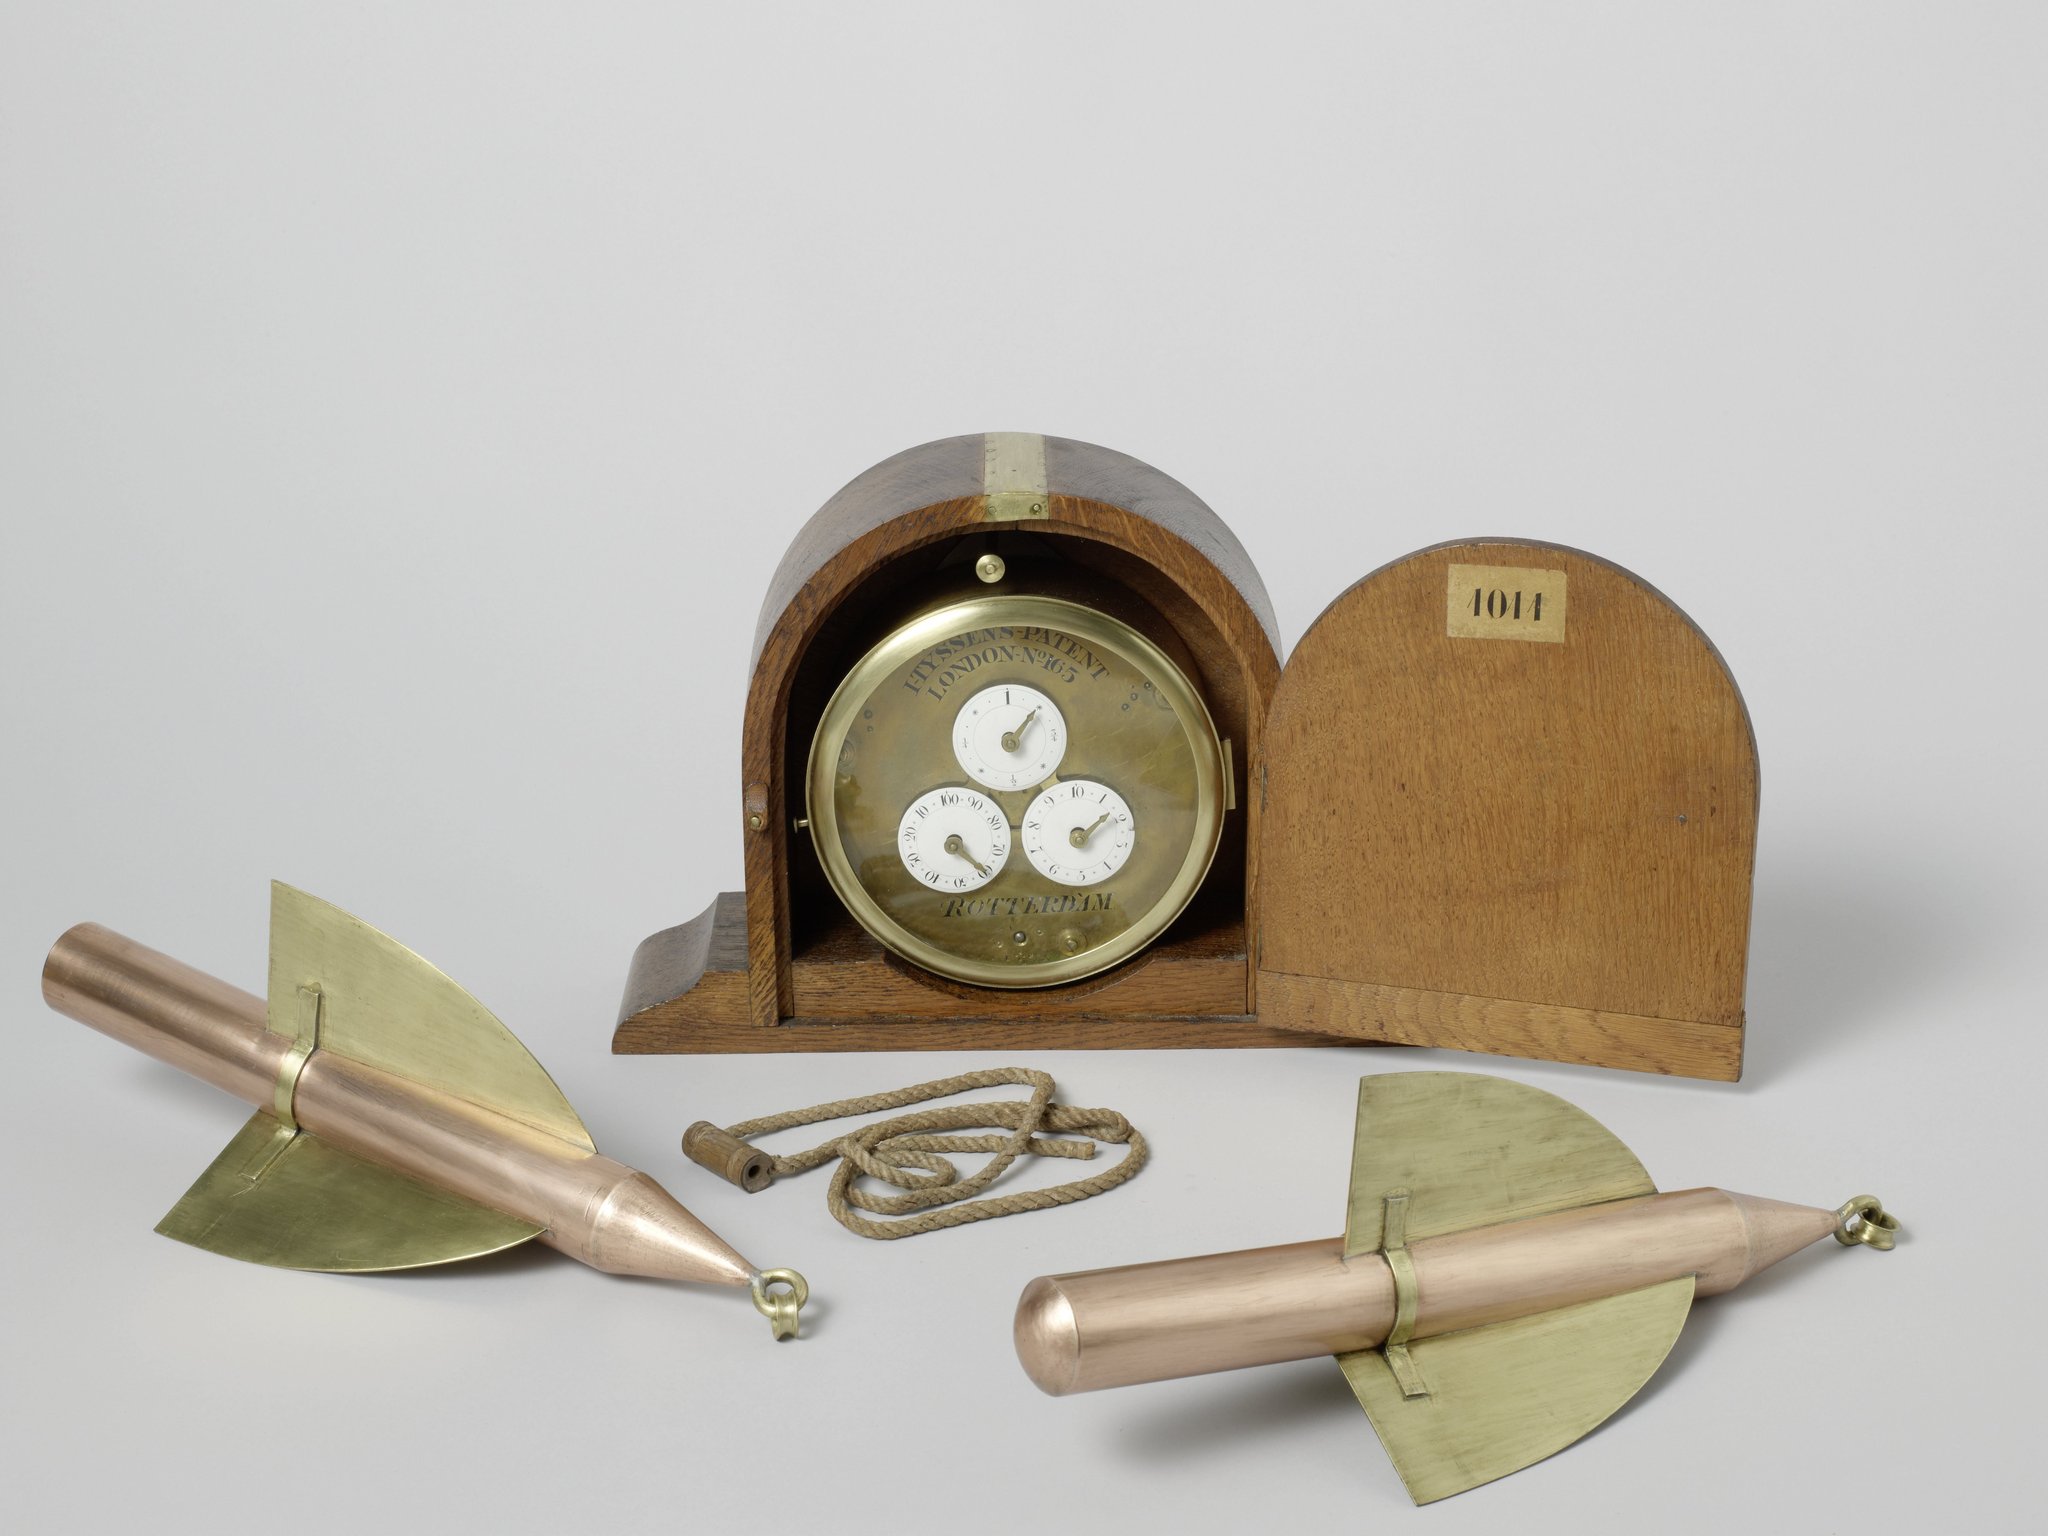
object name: rotating vane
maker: i. thyssen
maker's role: instrument maker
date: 1860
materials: brass, copper, iron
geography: rotterdam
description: Mechanisch log bestaande uit een heklog in een kastje en twee logvinnen, waarvan er een met een loglijn aan de keerzijde het heklog bevestigd moet worden; de tweede logvin dient als reserve. De logvinnen zijn cylindrische drijvers met drie schroefvormige vleugels, die het heklog in de richting van de klok aandrijven. Het ronde heklog heeft drie emaille wijzerplaten, voor 1 mijl (onderverdeeld in zestienden), 10 mijl en 100 mijl. [gecombineerde beschrijving]